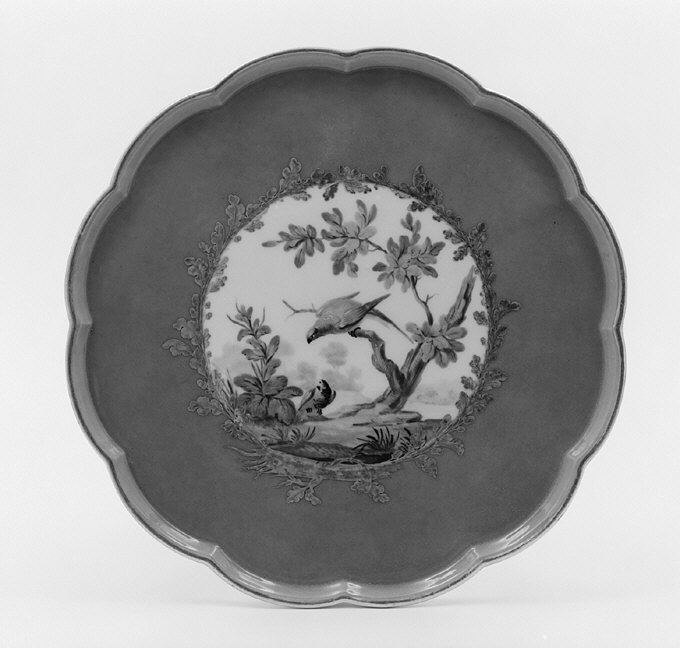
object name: fruit stand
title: Fruit stand (soucoupe à pied) (one of four) (part of a service)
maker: sèvres manufactory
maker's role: manufactory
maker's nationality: french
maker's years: 1740-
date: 1771-1772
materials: soft paste porcelain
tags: birds,trees